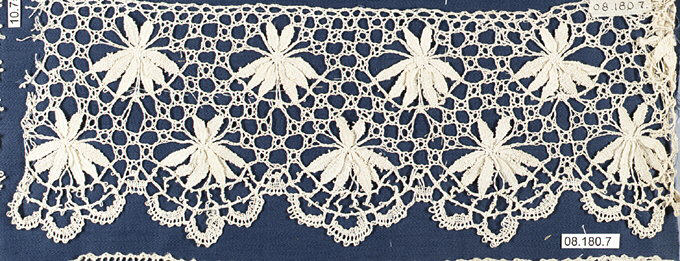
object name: fragment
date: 1801-1900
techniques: lace